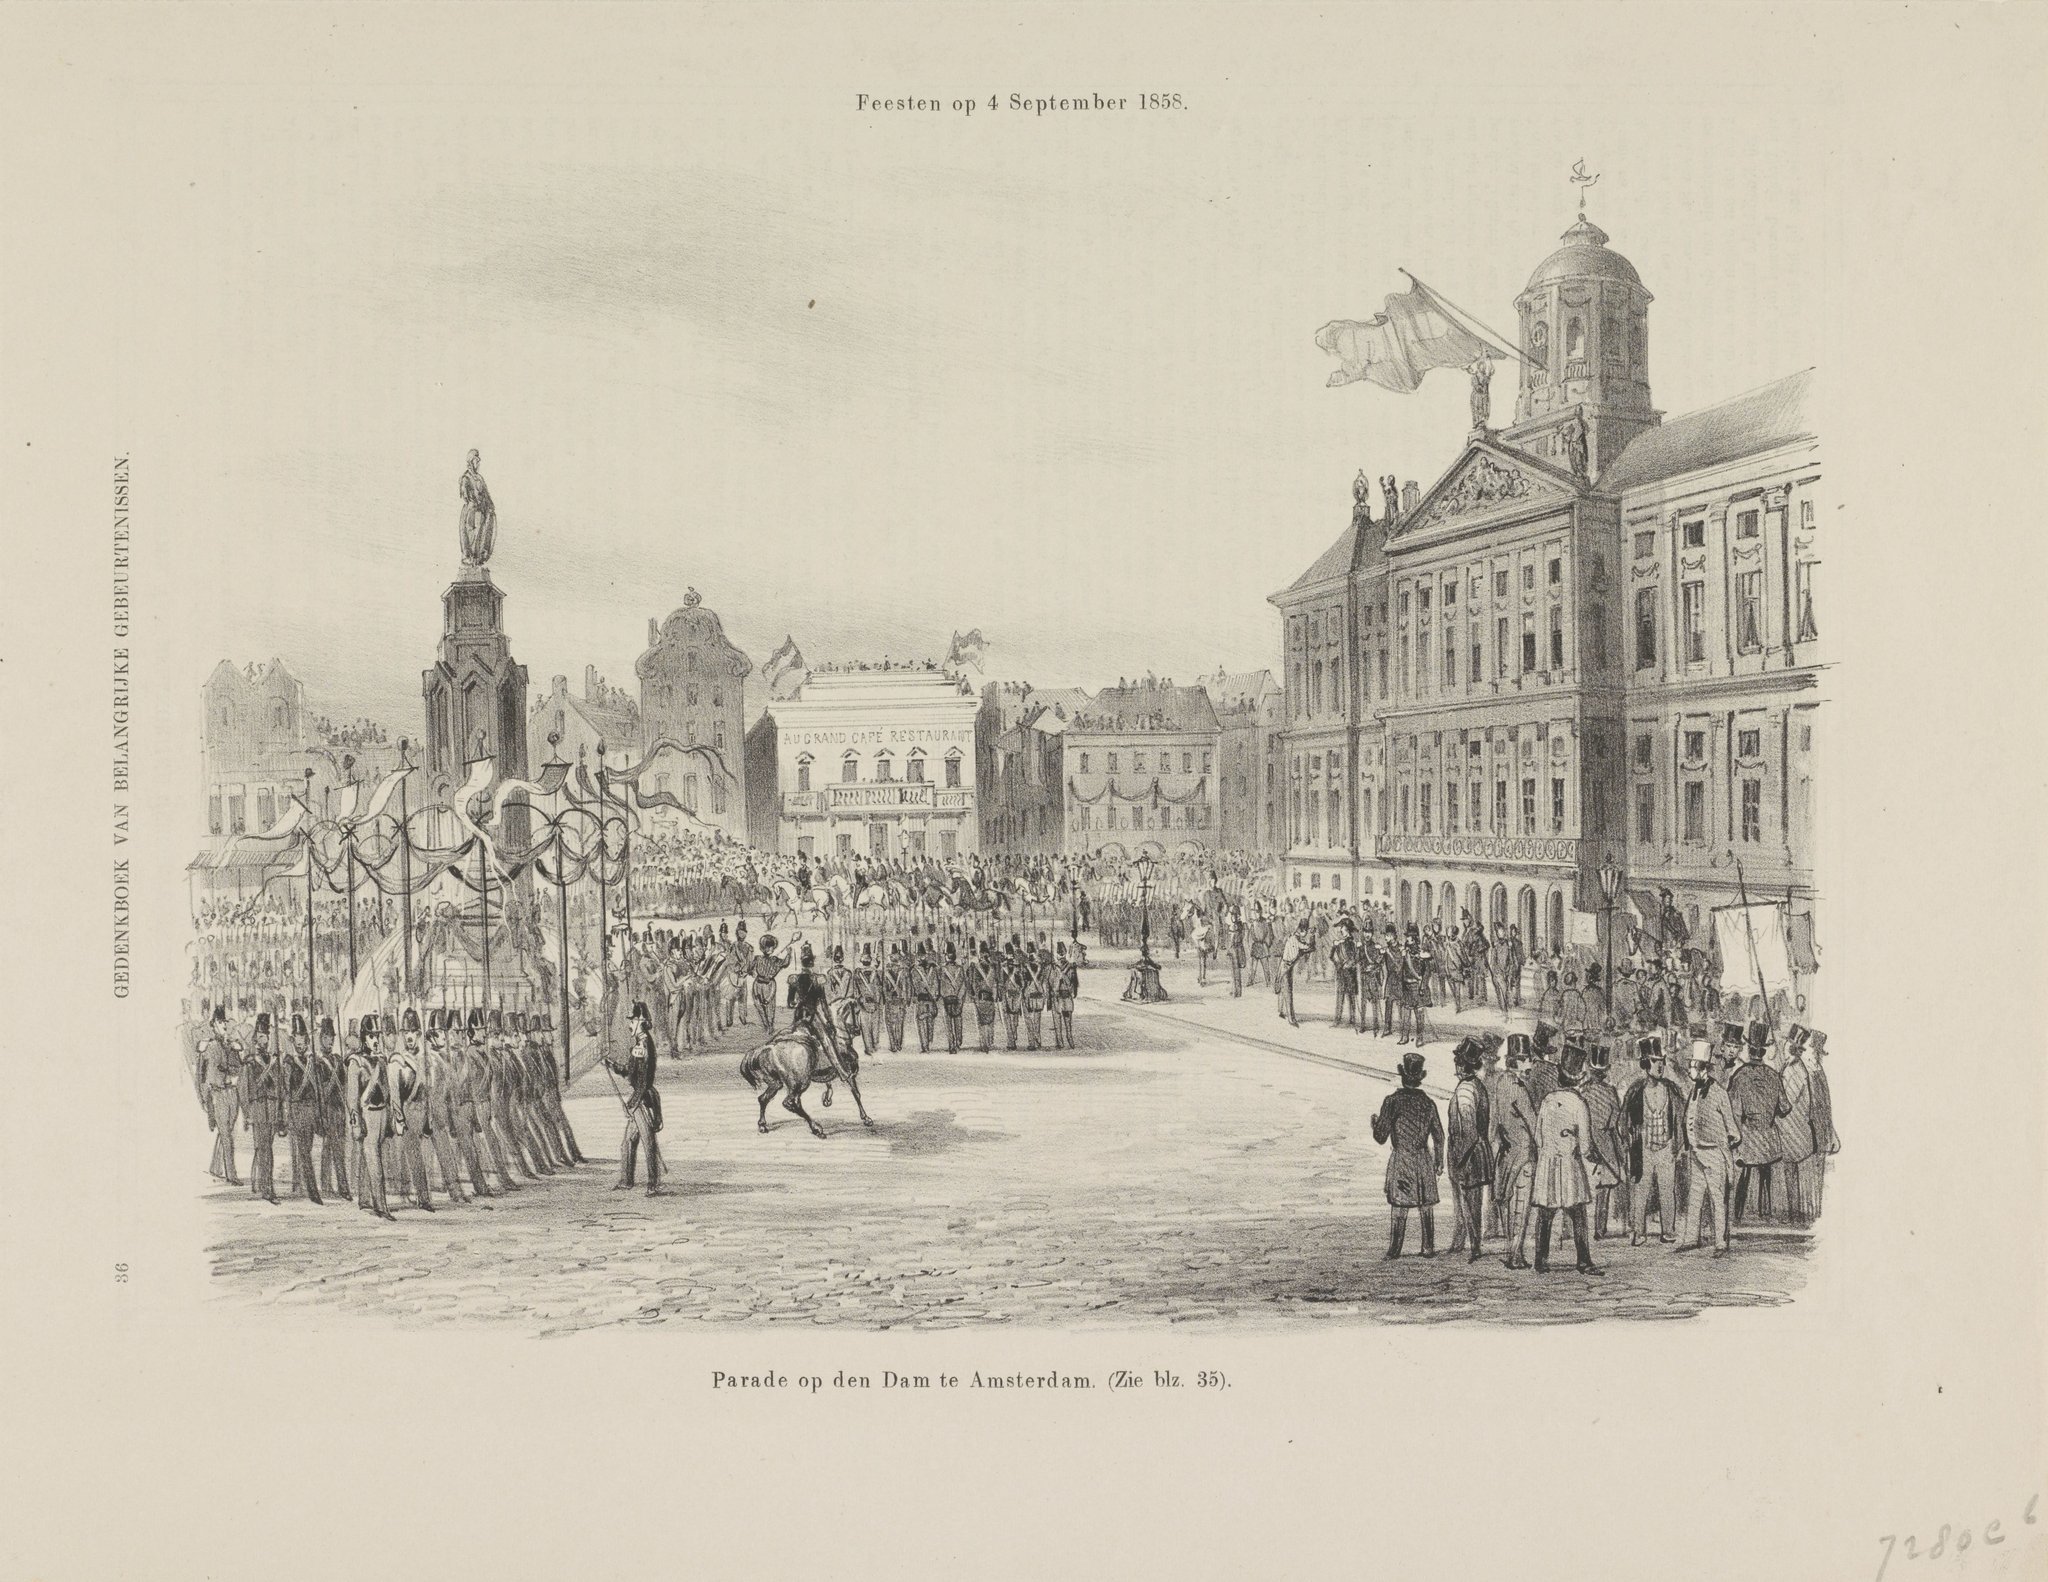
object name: print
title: Feesten op 4 September 1858 / Parade op den Dam te Amsterdam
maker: Anonymous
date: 1858-1859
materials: paper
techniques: lithograph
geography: netherlands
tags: paris, willem (prins der nederlanden), public festivities at other royal events, not meant or mentioned above, the hague, royal palace of amsterdam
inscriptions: collector's mark: Lugt 2228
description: Feestelijkheden voor het Paleis op de Dam te Amsterdam op 4 september 1858, ter gelegenheid van het meerderjarig worden van Willem, prins van Oranje-Nassau op 4 september 1858. Blad genummerd p. 36 en bedrukt met tekst op verso.